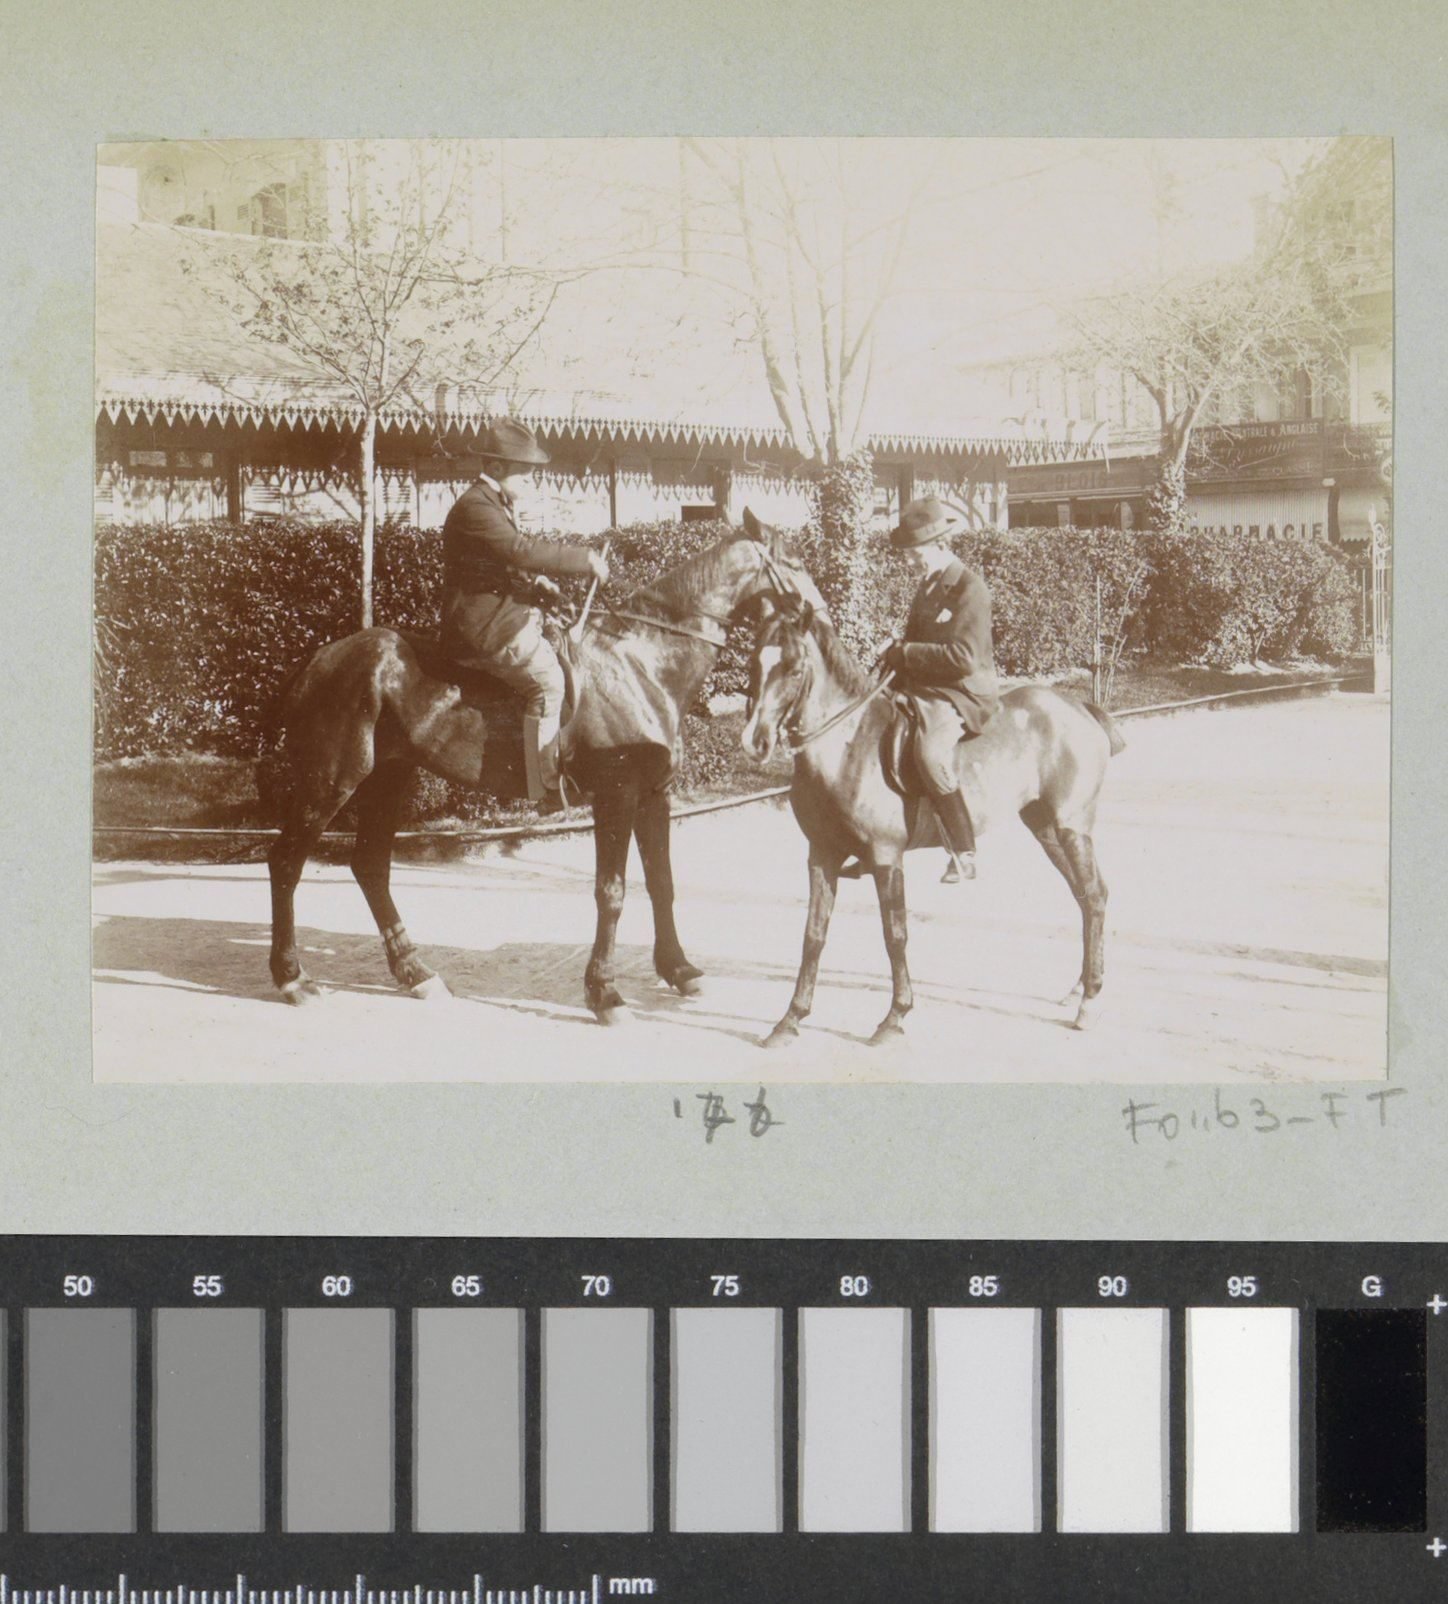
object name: photograph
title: Twee mannen te paard in een straat in Frankrijk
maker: delizy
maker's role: manufacturer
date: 1898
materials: paper, photographic support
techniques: gelatin silver print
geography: france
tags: riding a horse, ass, or mule; rider, horseman, france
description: Onderdeel van Fotoalbum van een Franse amateurfotograaf met opnames van uitstapjes in Frankrijk, Spanje, België, Luxemburg en Nederland, de eerste automobielen en autoraces.